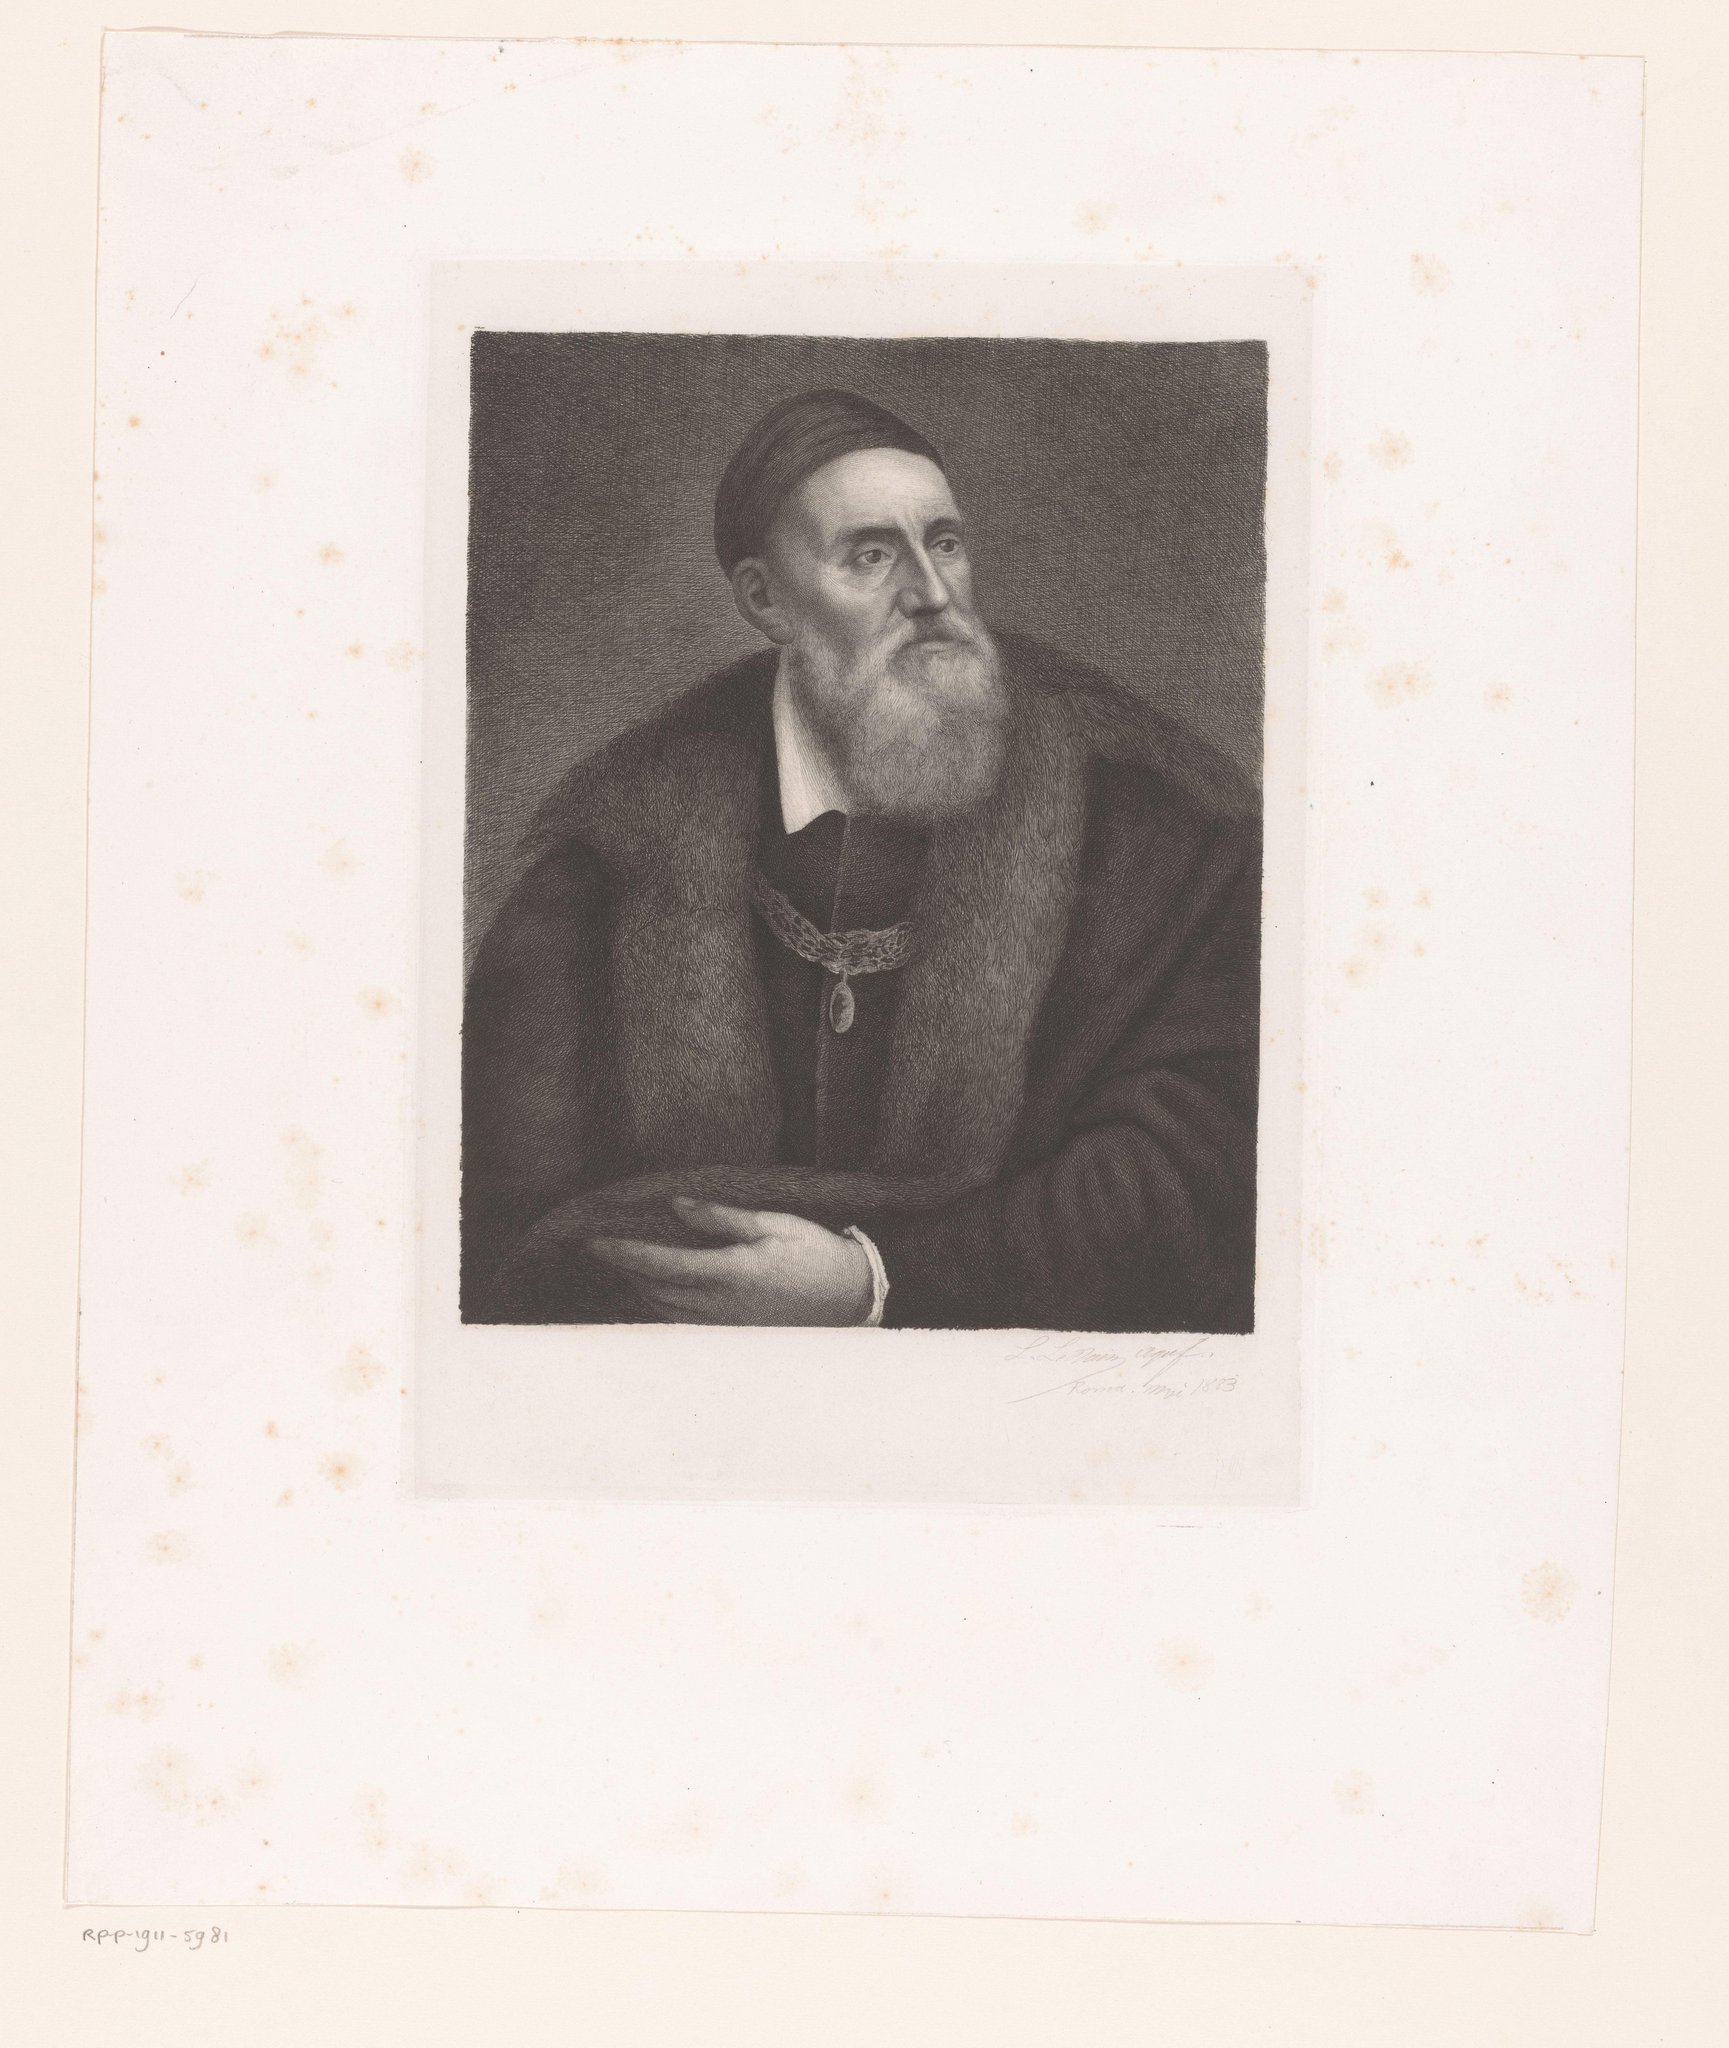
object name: print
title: Portret van een onbekende man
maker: louis le nain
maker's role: print maker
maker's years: 1851-1939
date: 1883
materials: paper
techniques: etching, intaglio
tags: adult man, historical persons, beard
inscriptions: collector's mark: Lugt 2228, inscription: ‘L. Le Nain aquf. Roma mai 1883’